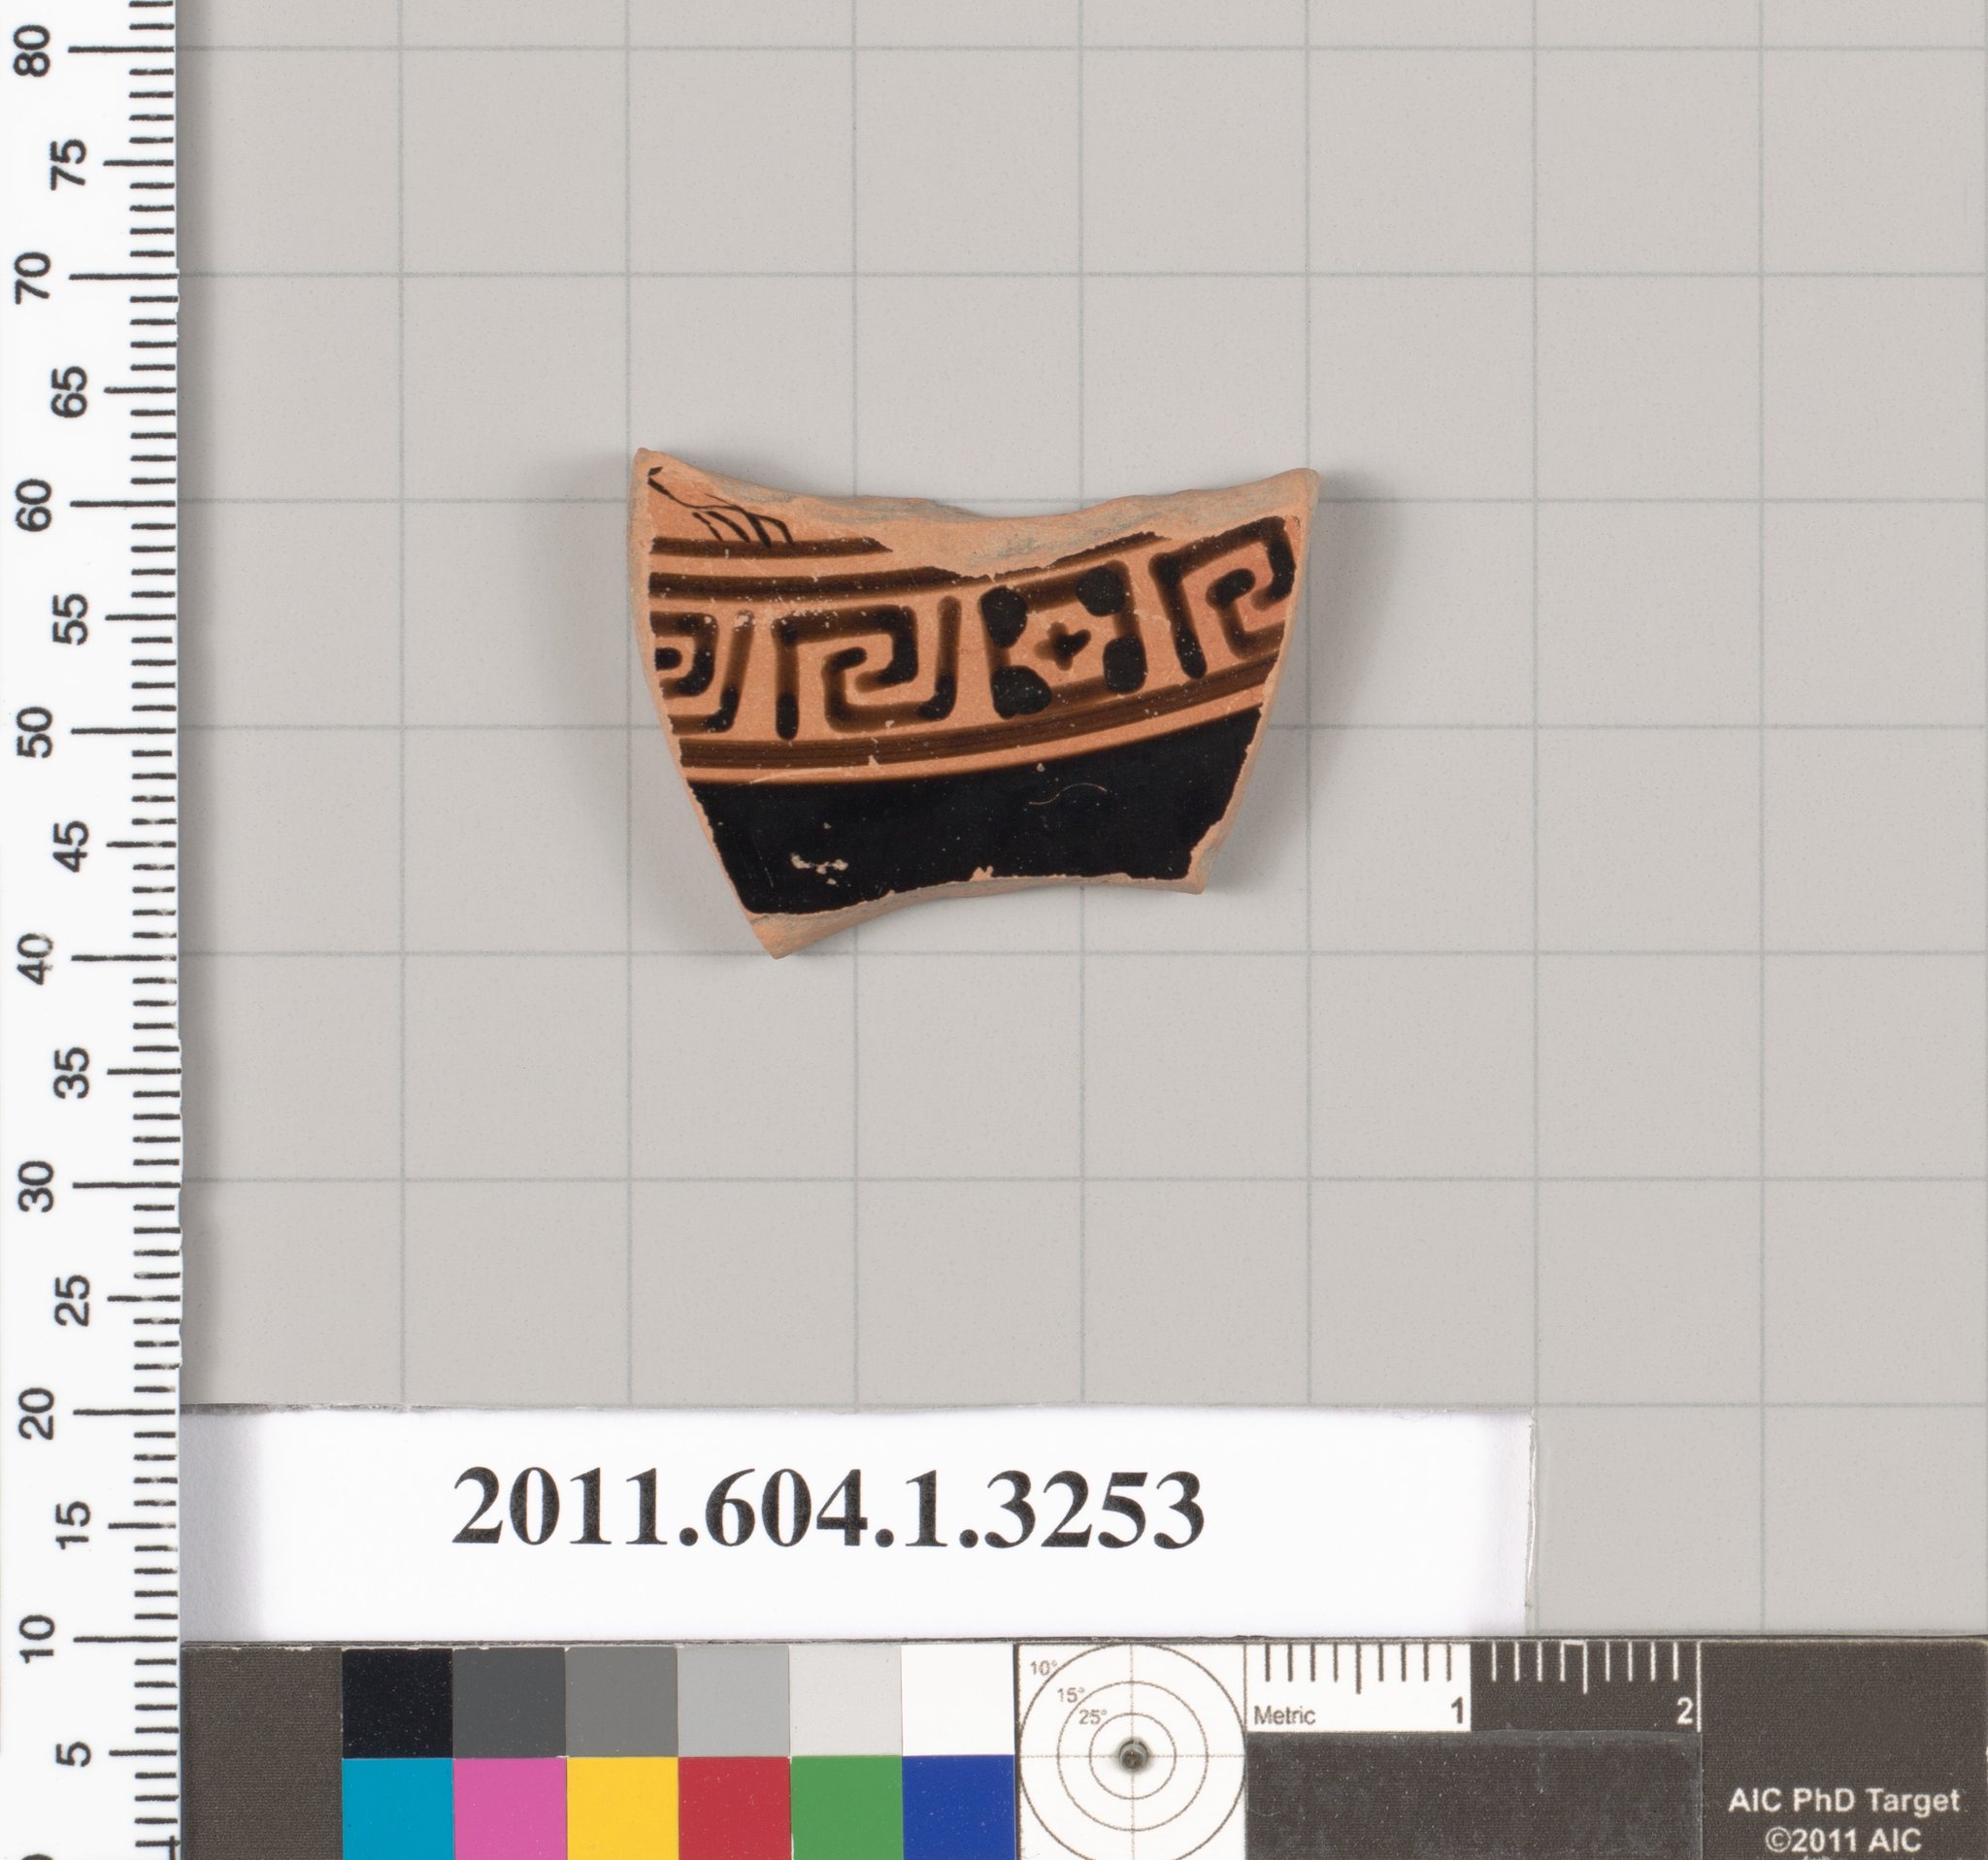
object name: kylix fragment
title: Terracotta fragment of a kylix (drinking cup)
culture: greek, attic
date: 475-451 BCE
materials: terracotta